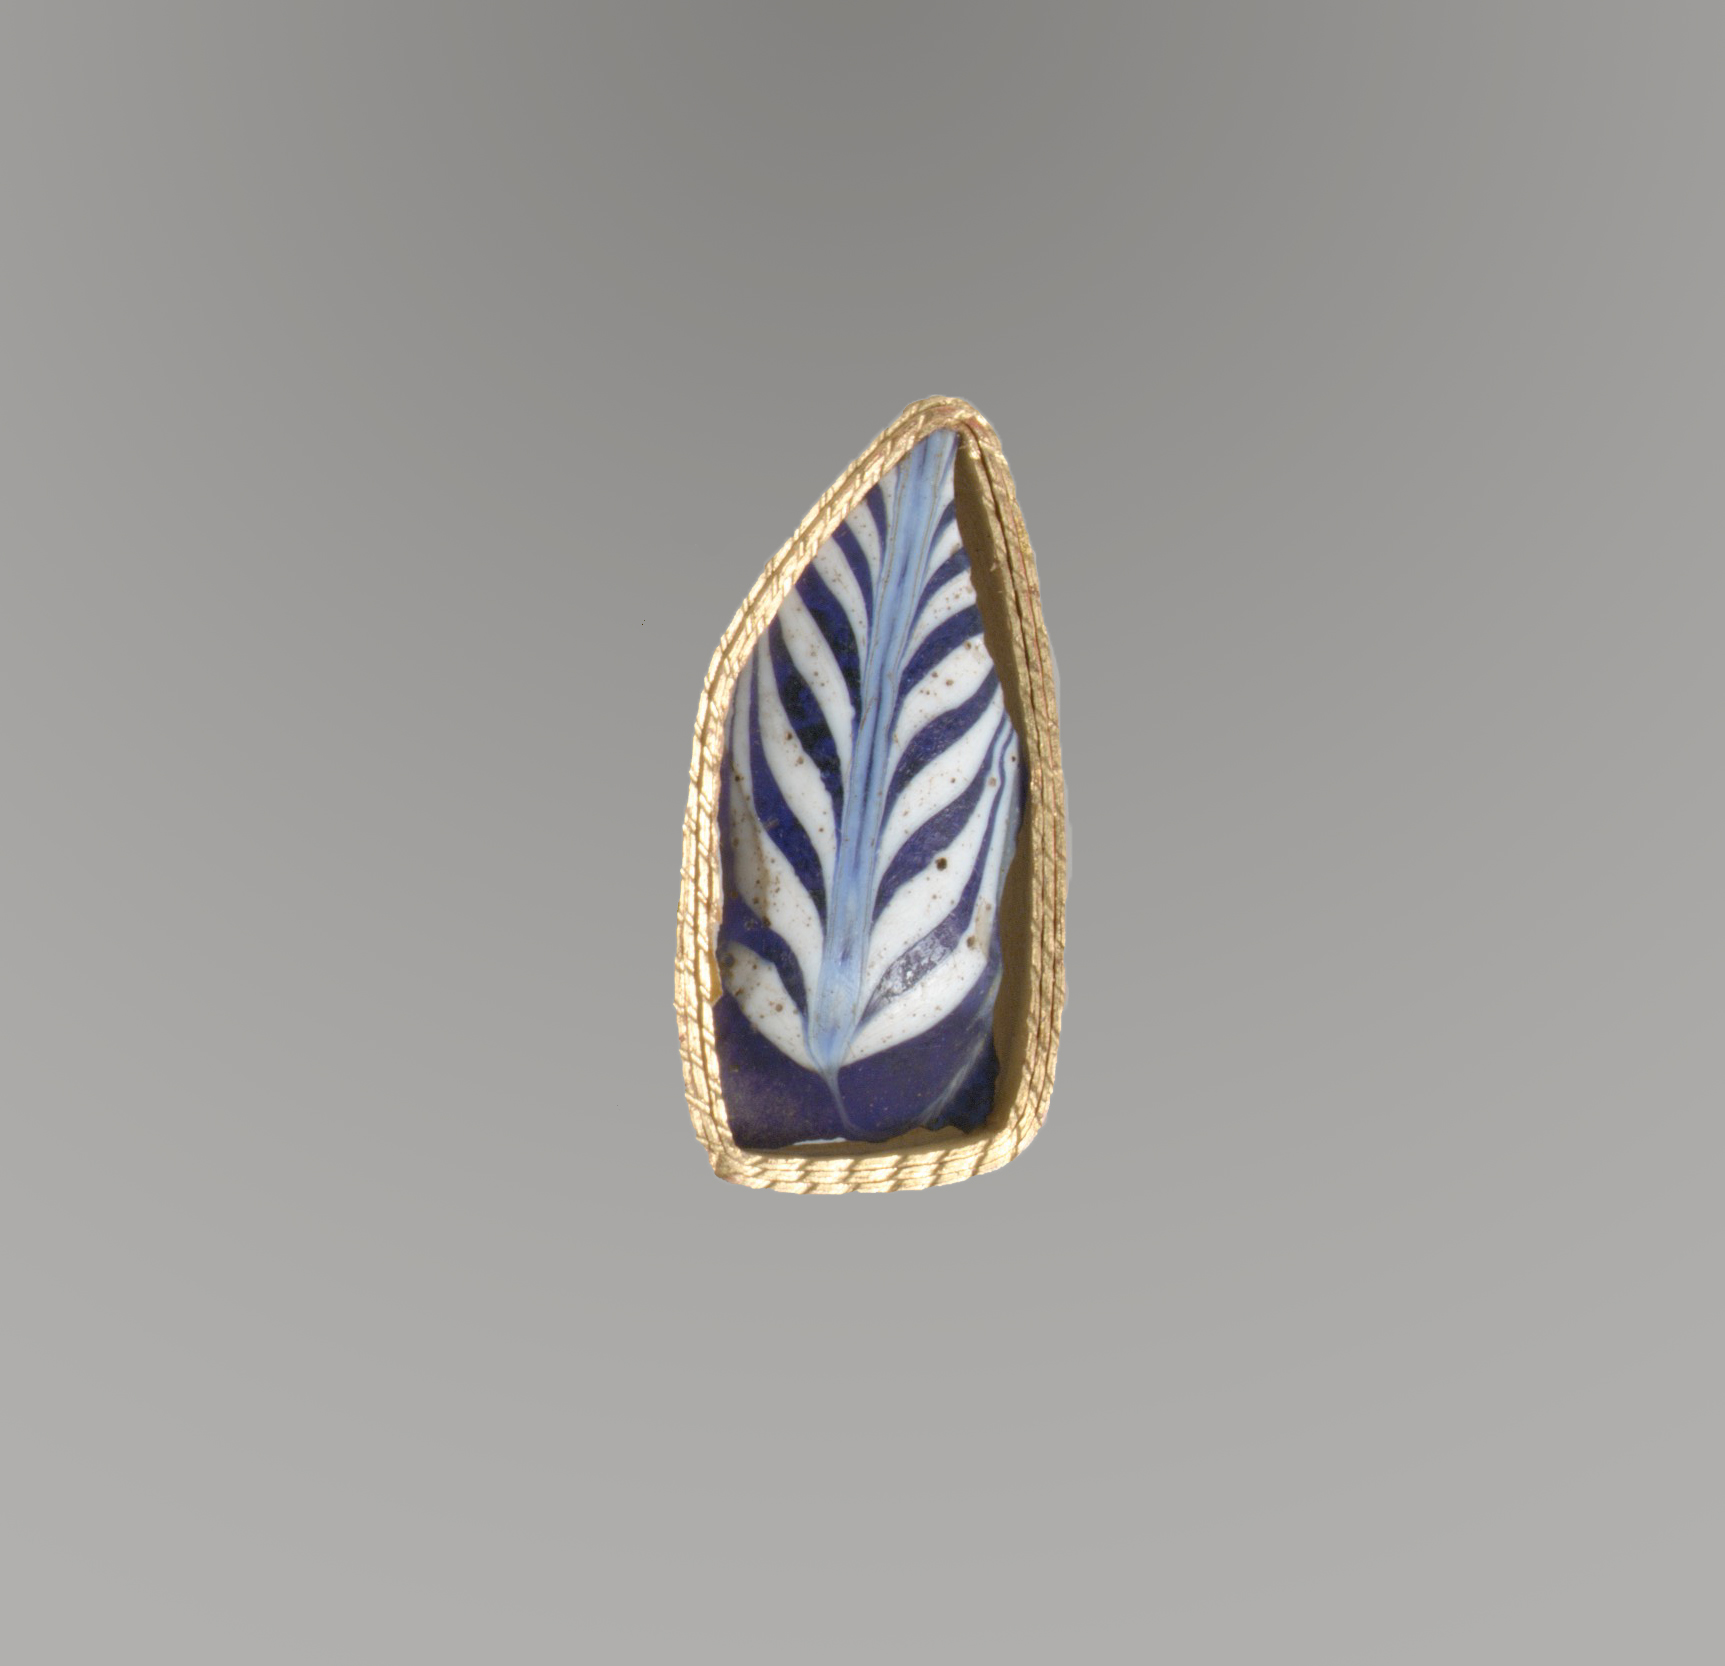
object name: fragment, body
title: Glass bottle fragment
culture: eastern mediterranean or italian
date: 400-201 BCE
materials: glass